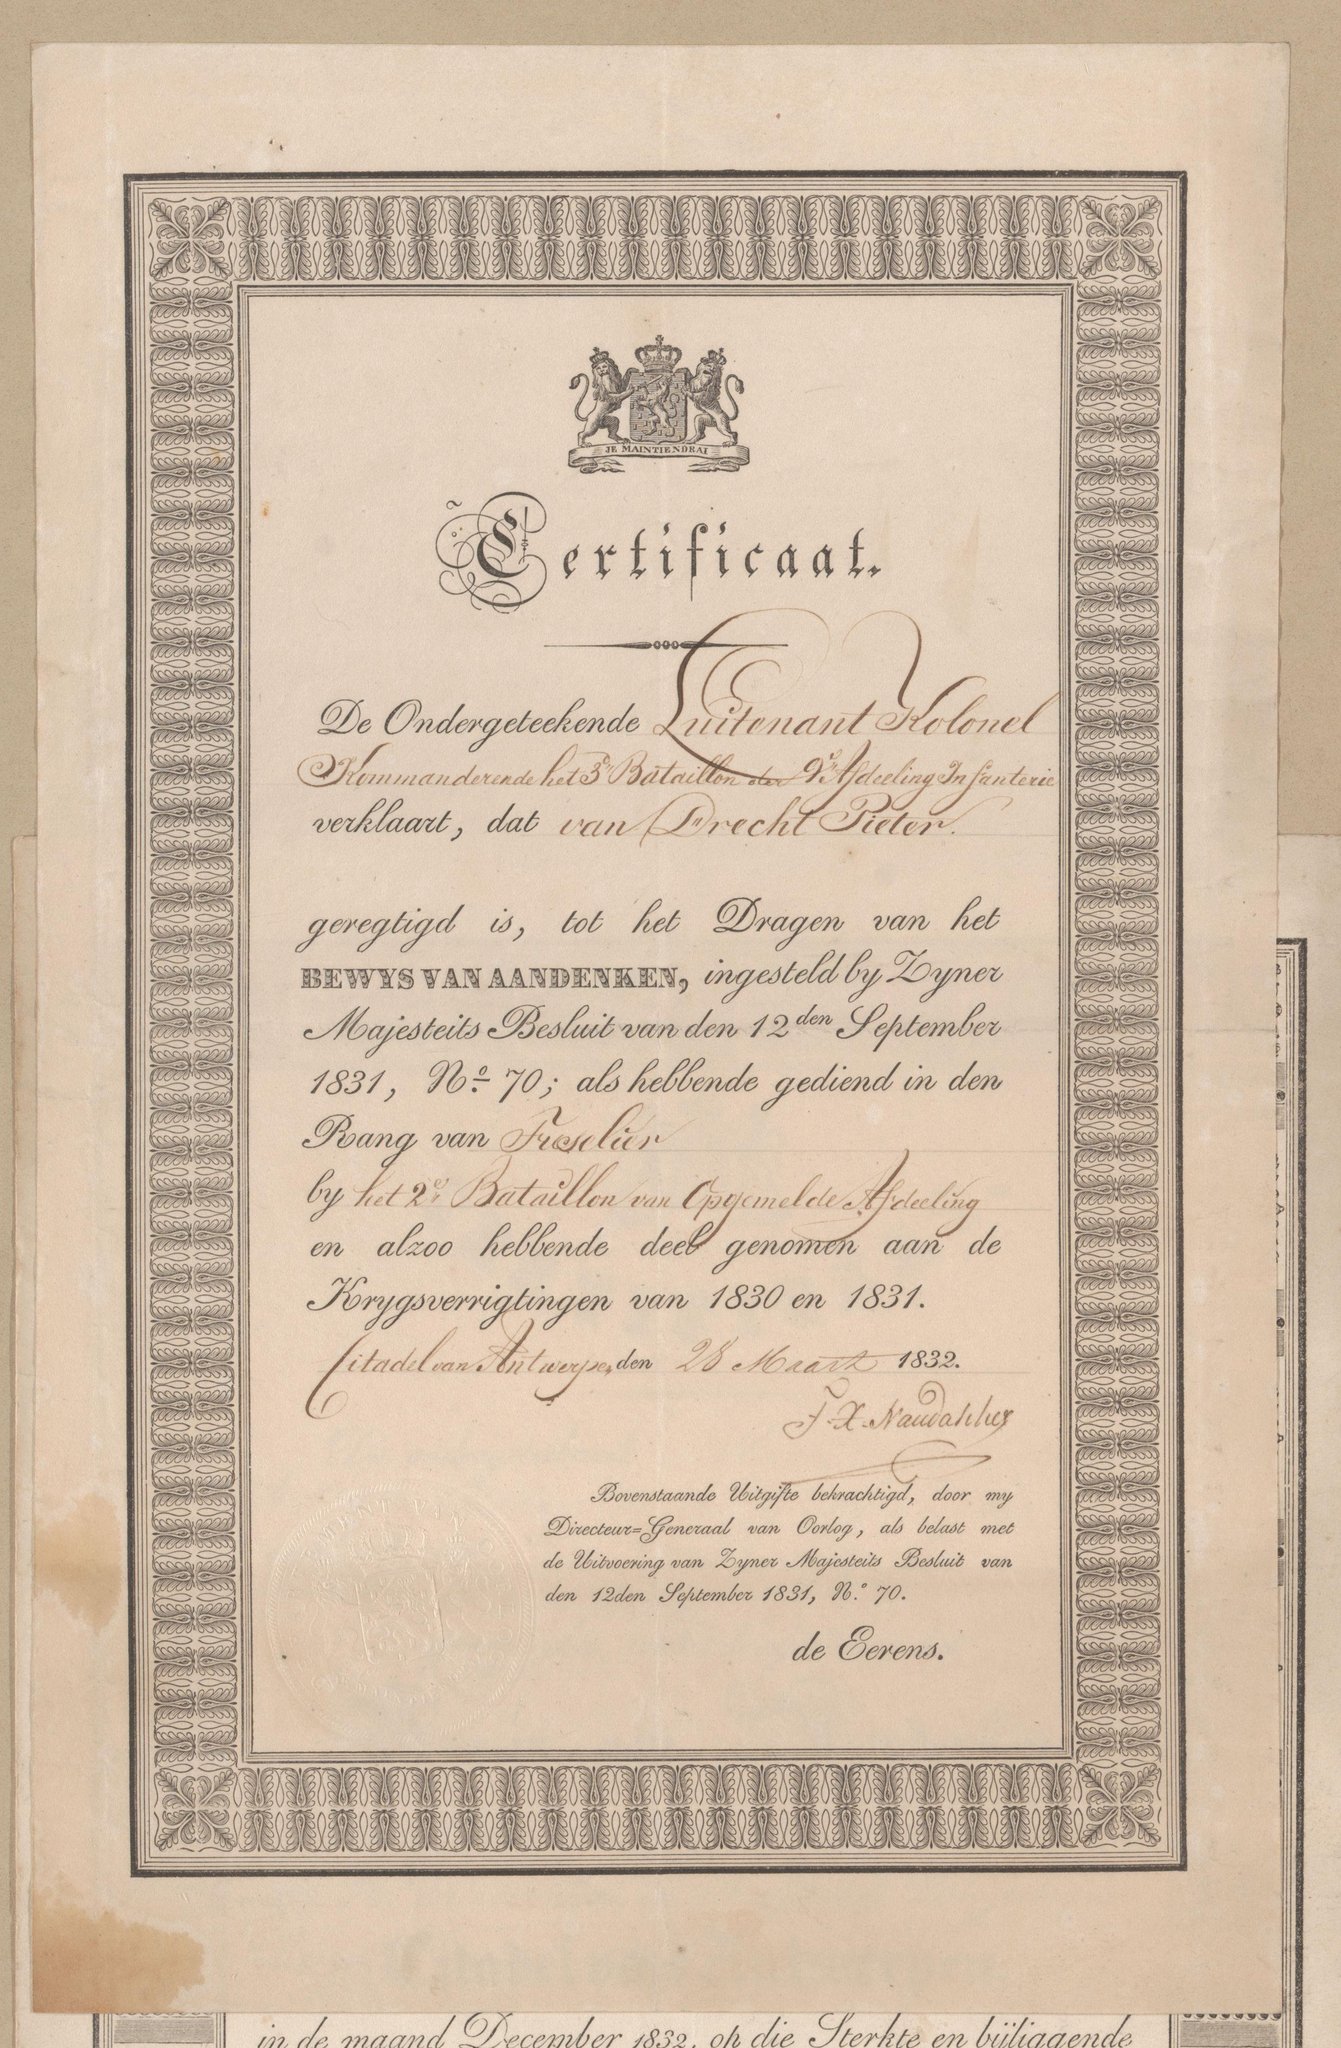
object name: text sheet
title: Certificaat van Pieter van Drecht voor zijn deelname aan gevechten tijdens de Belgische Revolutie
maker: Anonymous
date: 1832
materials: paper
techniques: letterpress printing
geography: netherlands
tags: military honours, southern netherlands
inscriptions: coat of arms: ‘Departement van Oorlog’, collector's mark: Lugt 1641b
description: Onderwerpsrubriek binnen de Atlas Amsterdam: Landmacht: Gebouwen / Herinneringen aan officieren, stadssoldaten / Nationale militie / (diverse korpsen) / Padvinders / Parade.